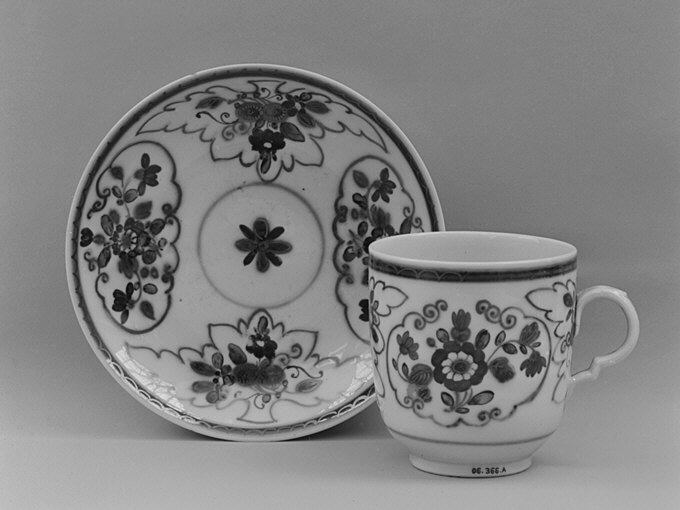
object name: cup and saucer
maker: doccia porcelain manufactory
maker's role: manufactory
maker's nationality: italian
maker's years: 1737-1896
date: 1751-1800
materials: hard paste porcelain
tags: flowers